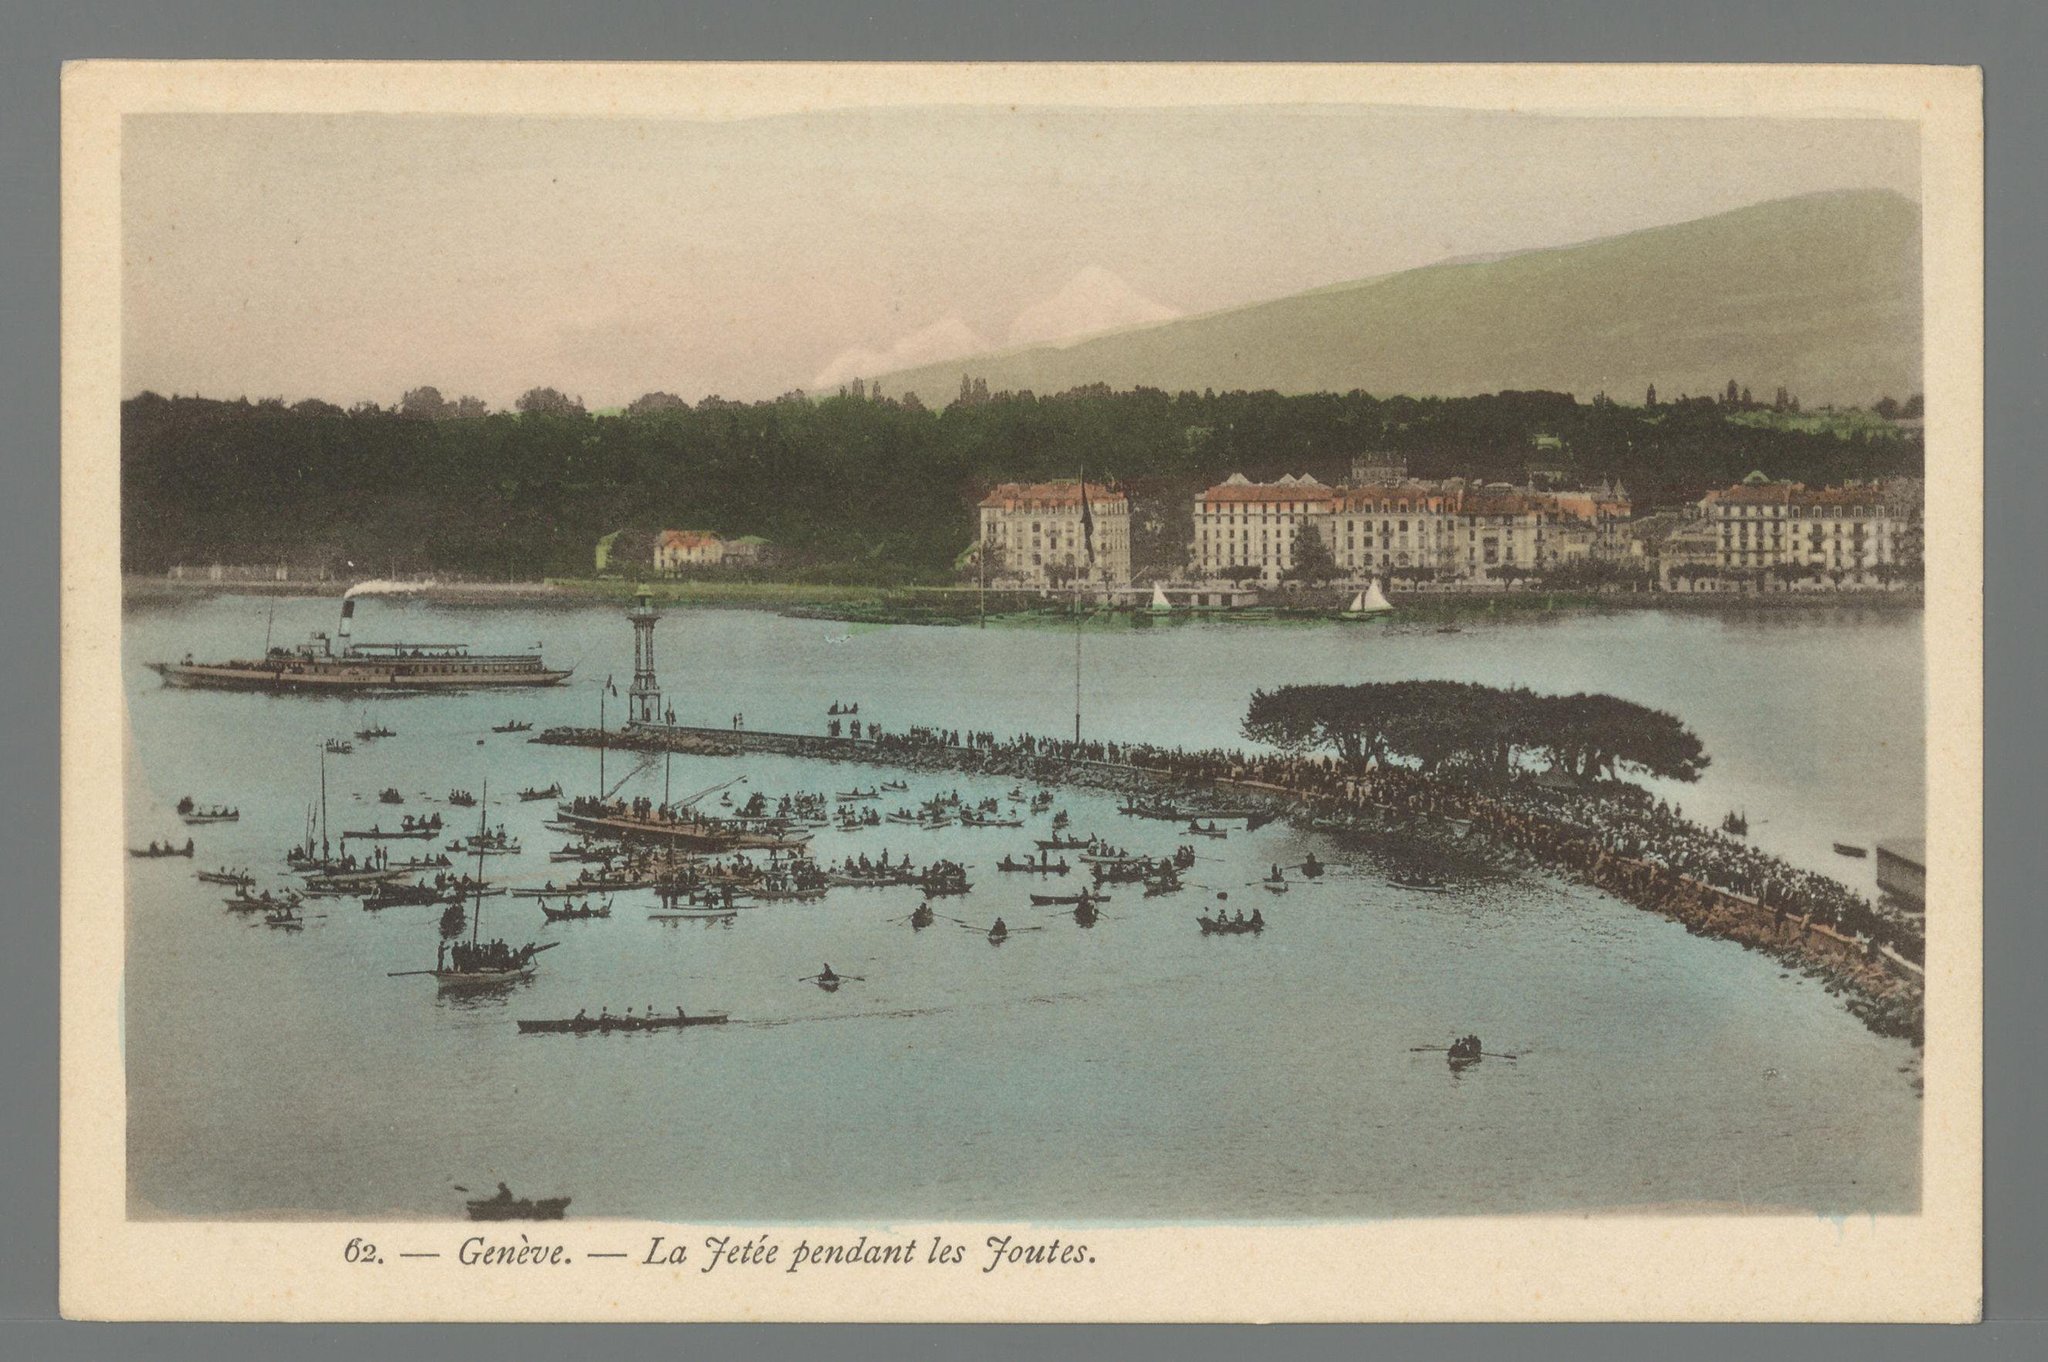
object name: ansichtkaart, prentbriefkaart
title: Genève. La Jetée pendant les Joutes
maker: Anonymous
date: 1905-1909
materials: cardboard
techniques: photograph, lithograph, writing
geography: geneva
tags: ships (in general), lake, pier, quay, wharf